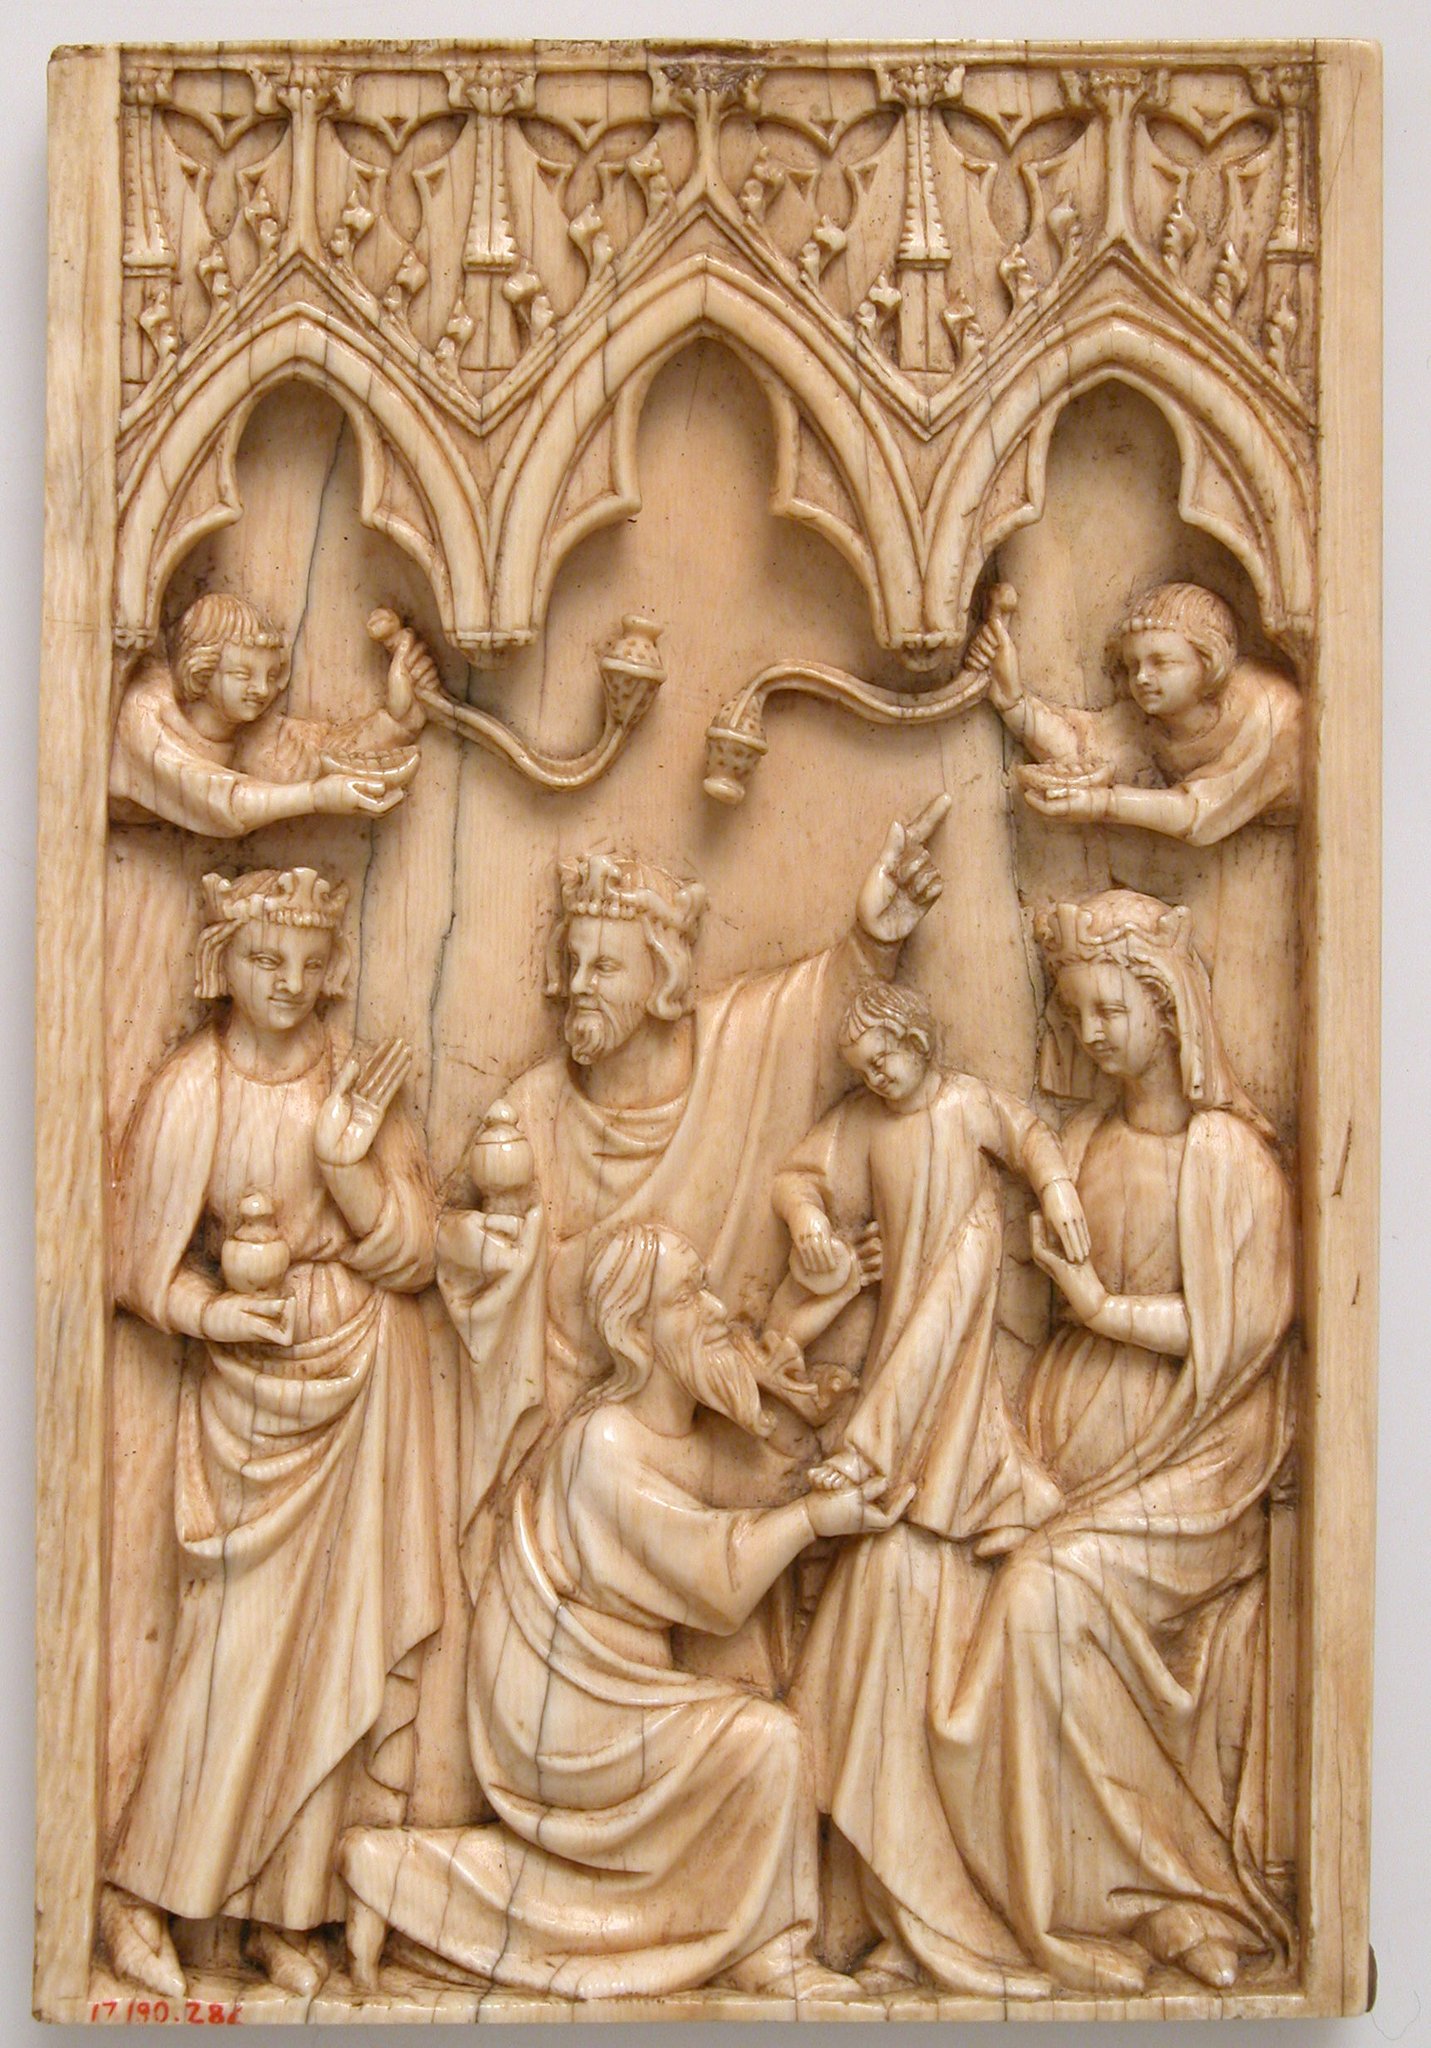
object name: diptych leaf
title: Panel with the Adoration of the Magi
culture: european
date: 1801-1900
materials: ivory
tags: men,madonna and child